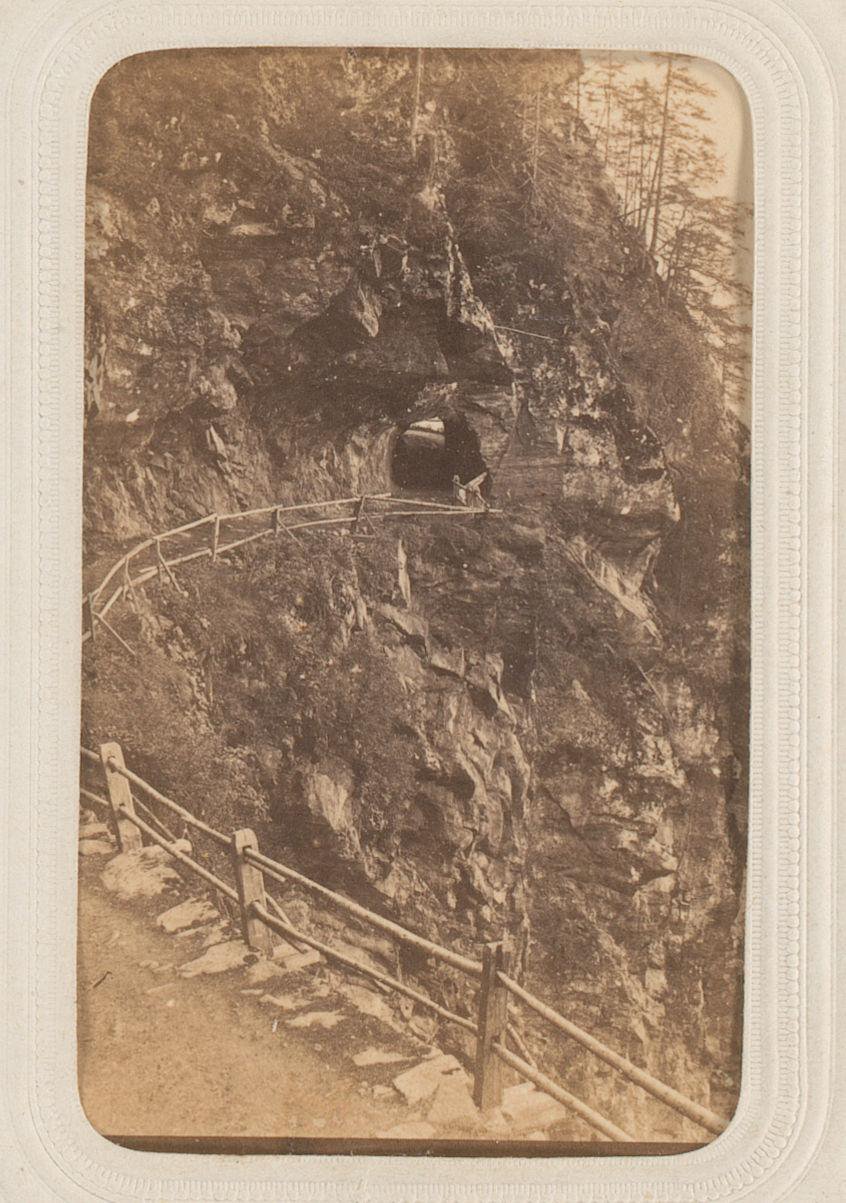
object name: photograph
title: Gezicht op een bergpad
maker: Anonymous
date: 1860-1885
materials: cardboard, photographic support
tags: road, path, mountains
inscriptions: inscription: ‘129. Galerie de tête noir’